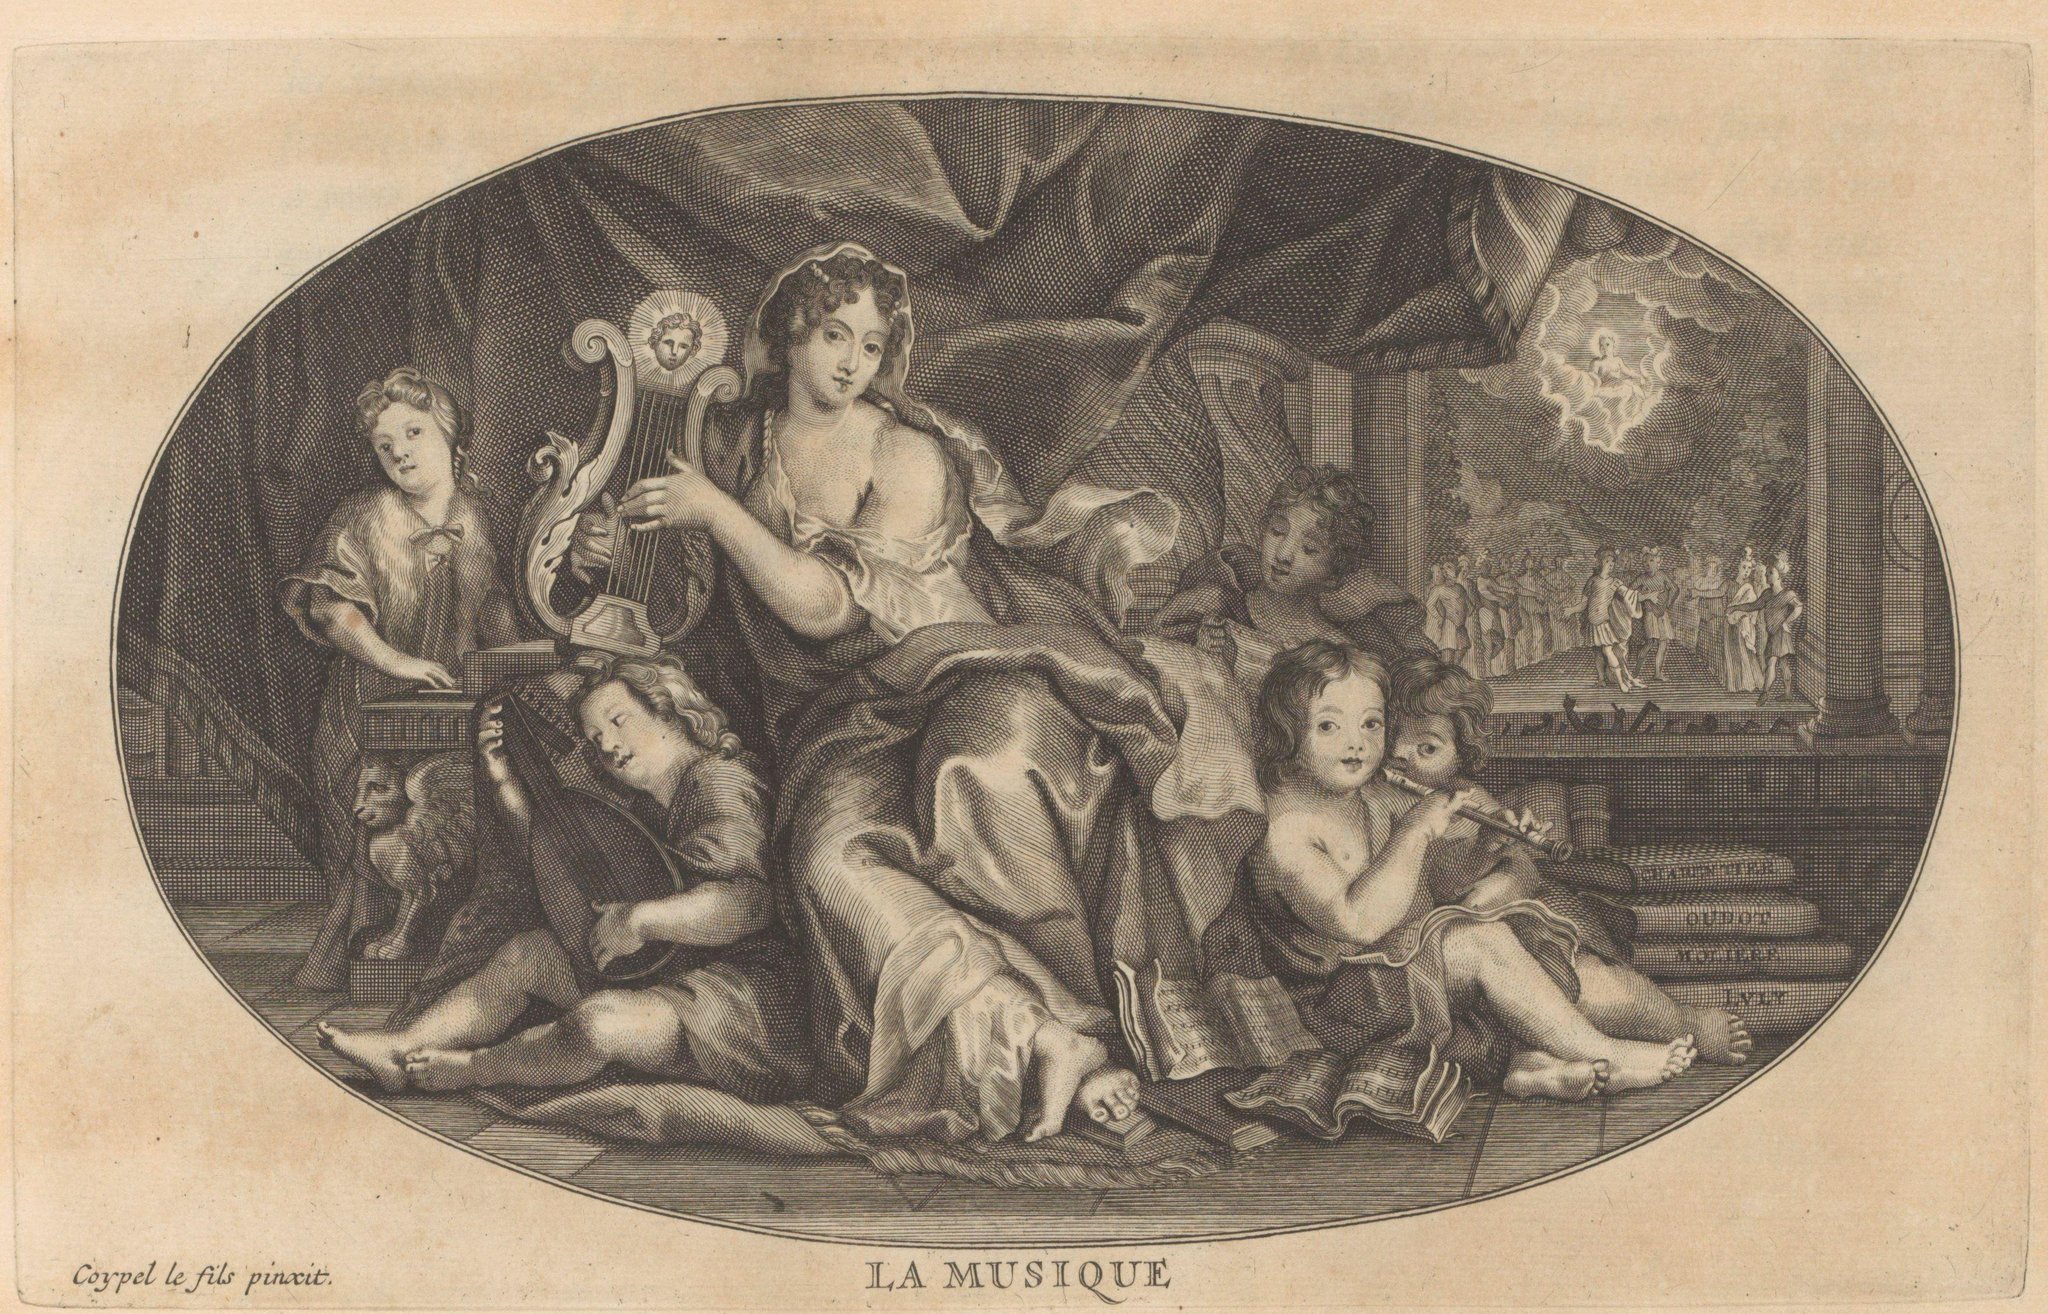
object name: album leaf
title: Muziek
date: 1695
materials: paper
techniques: engraving, etching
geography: paris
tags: madame de maintenon, 'musica', symbolic representations, allegories and emblems ~ music; 'musica'(ripa), (decorated) ceiling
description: Plafondstuk met de personificatie van Muziek die de lier bespeelt. Tevens het portret van Madame de Maintenon, tweede vrouw en maitresse van Lodewijk XIV. Rondom haar kinderen die de fluit, luit en klavecimbel bespelen. Rechts het toneel van een opera. Prent maakt deel uit van een album.